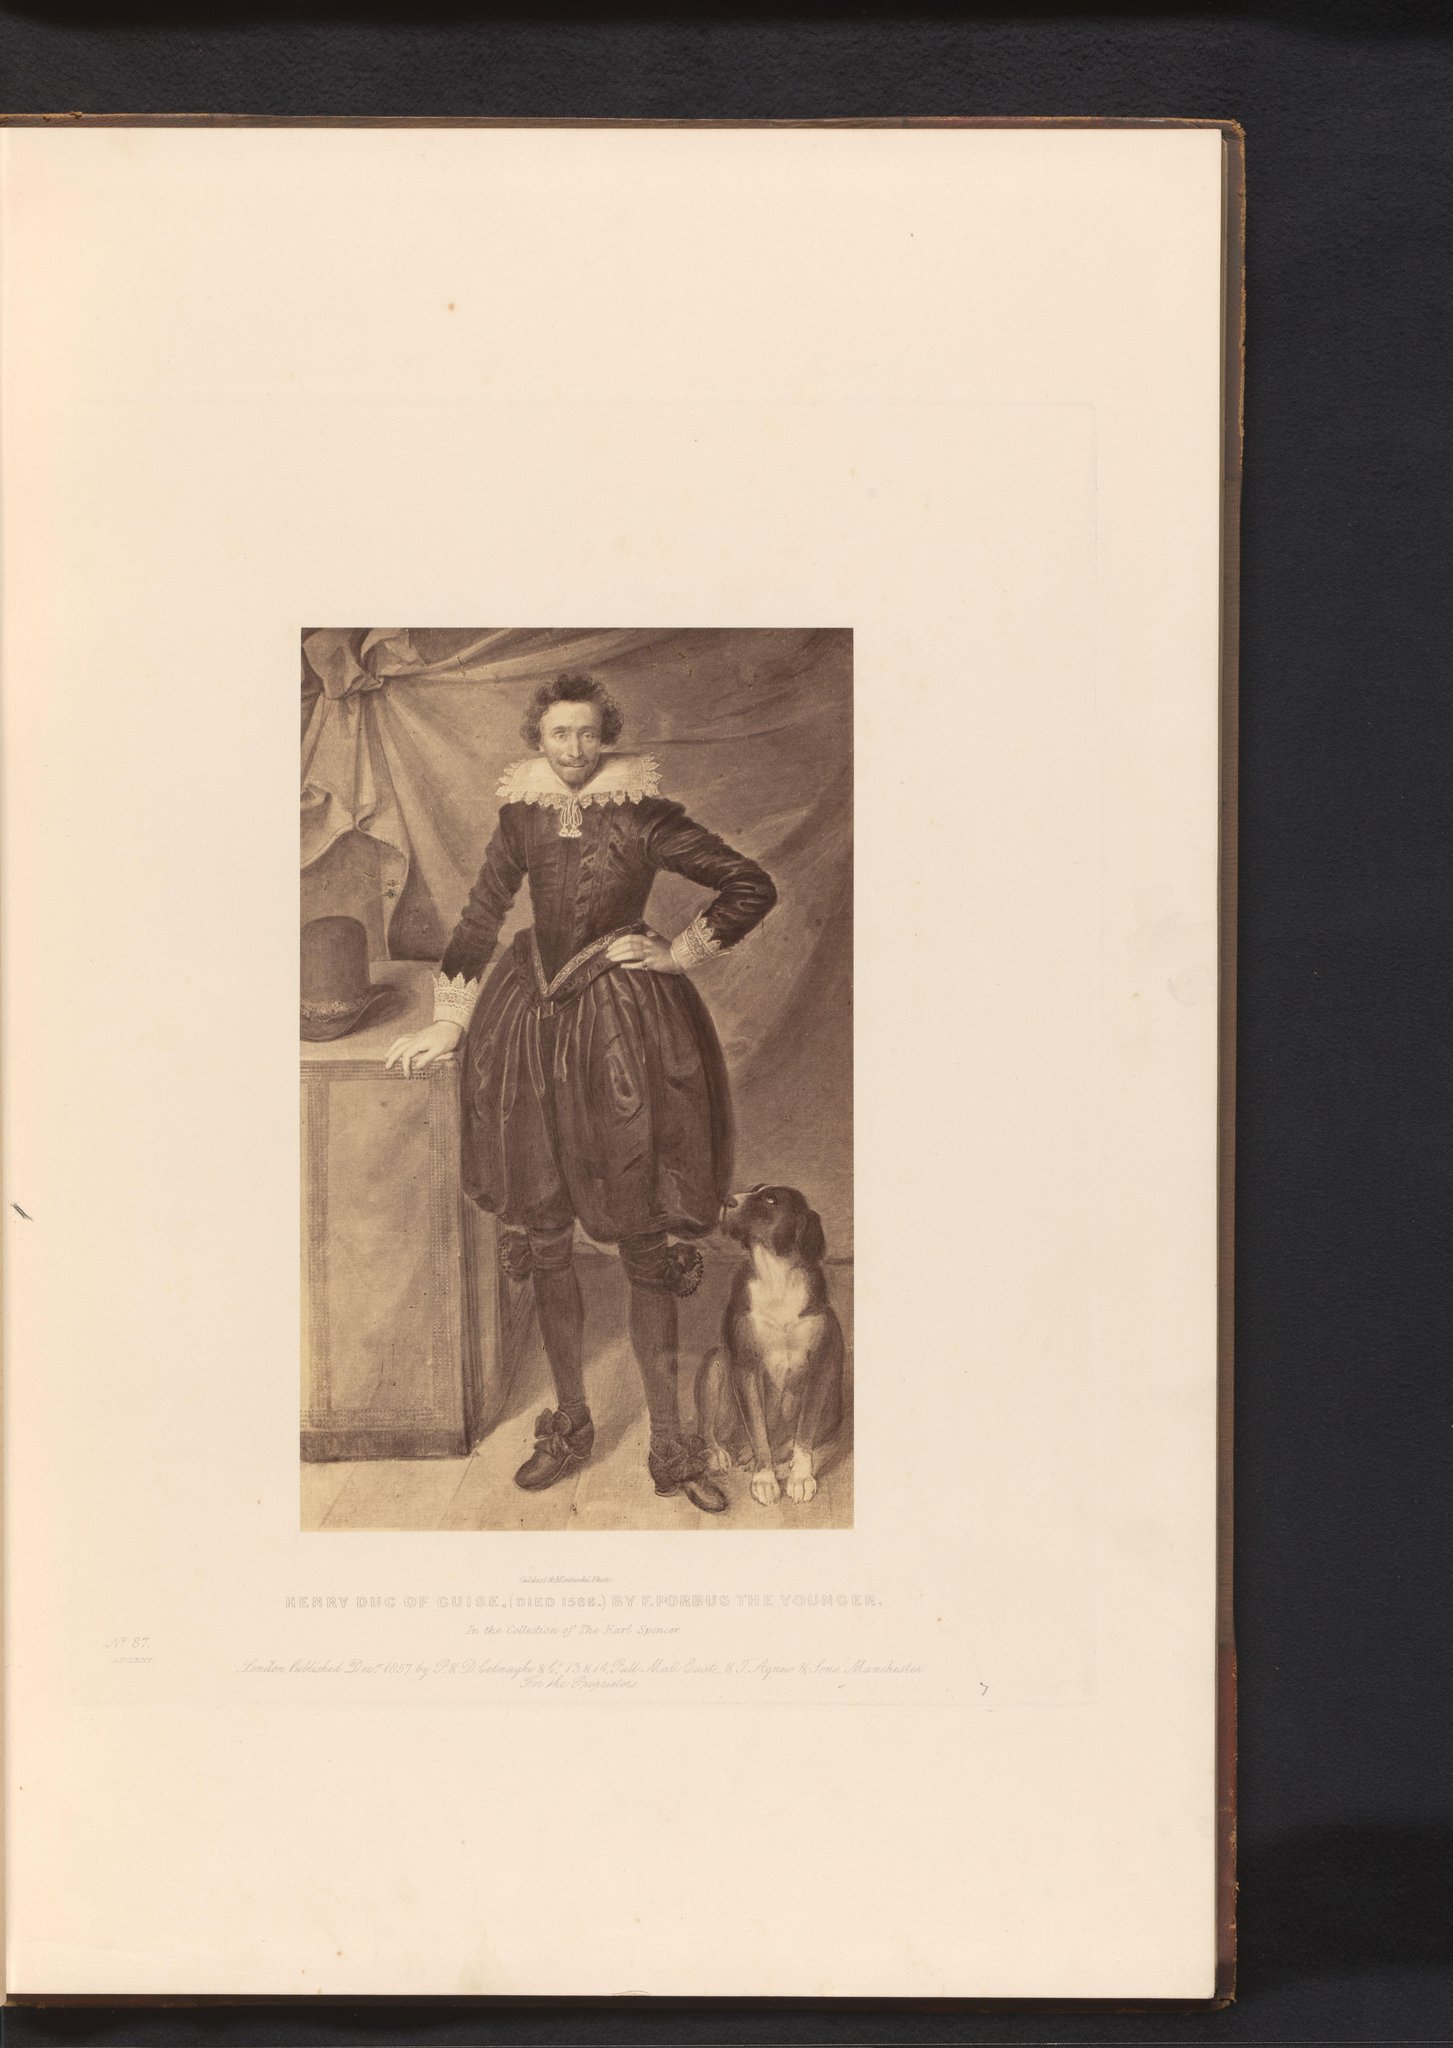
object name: reproduction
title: Fotoreproductie van een schilderij van een portret van Hendrik I van Guise door Frans Pourbus II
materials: photographic support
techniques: albumen print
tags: politician, historical persons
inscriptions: number: ‘No. 87./ ANCIENT.’, number: ‘7’, inscription: ‘In the Collection of The Earl Spencer./ London, Published Decr, 1857, by P. & D. Colnaghi & Co, 13 & 14, Pall Mall East & T. Agneur & Sons, Manchester./ For the Proprietors.’